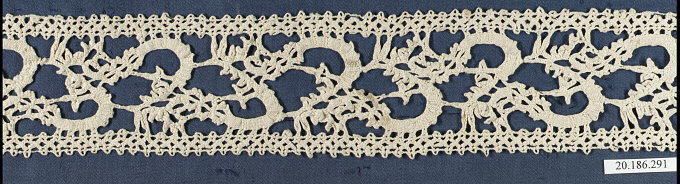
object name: insertion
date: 1601-1700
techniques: lace